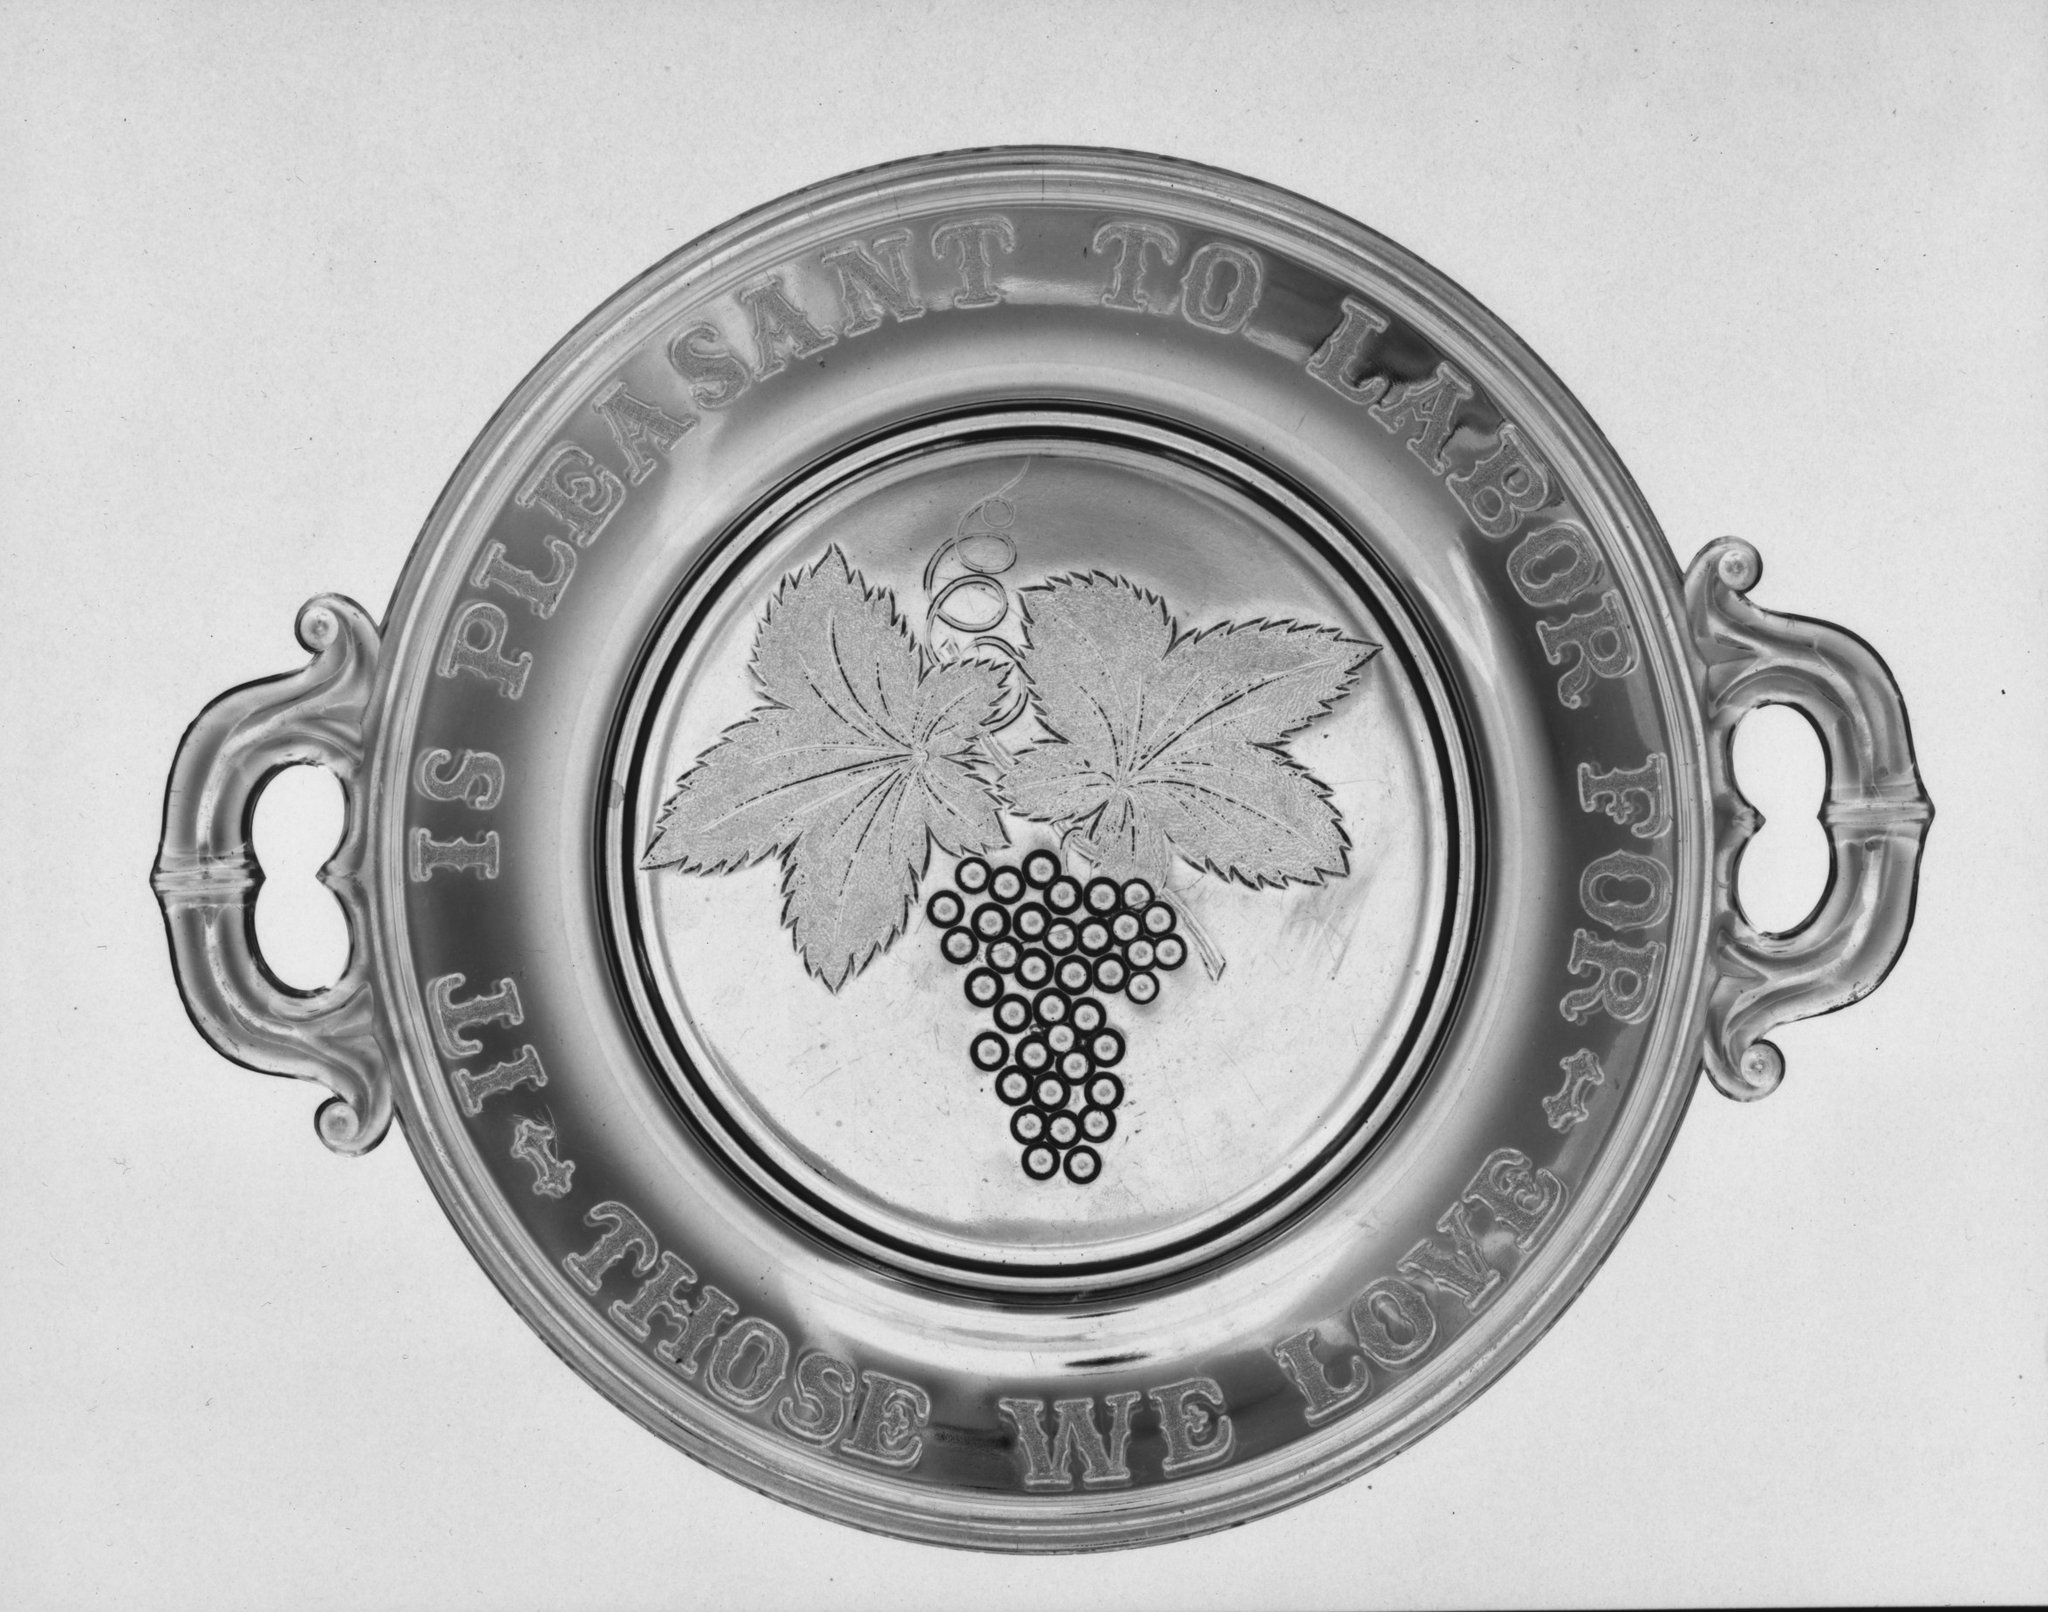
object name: bread plate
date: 1870-1890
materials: glass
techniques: pressed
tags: grapes